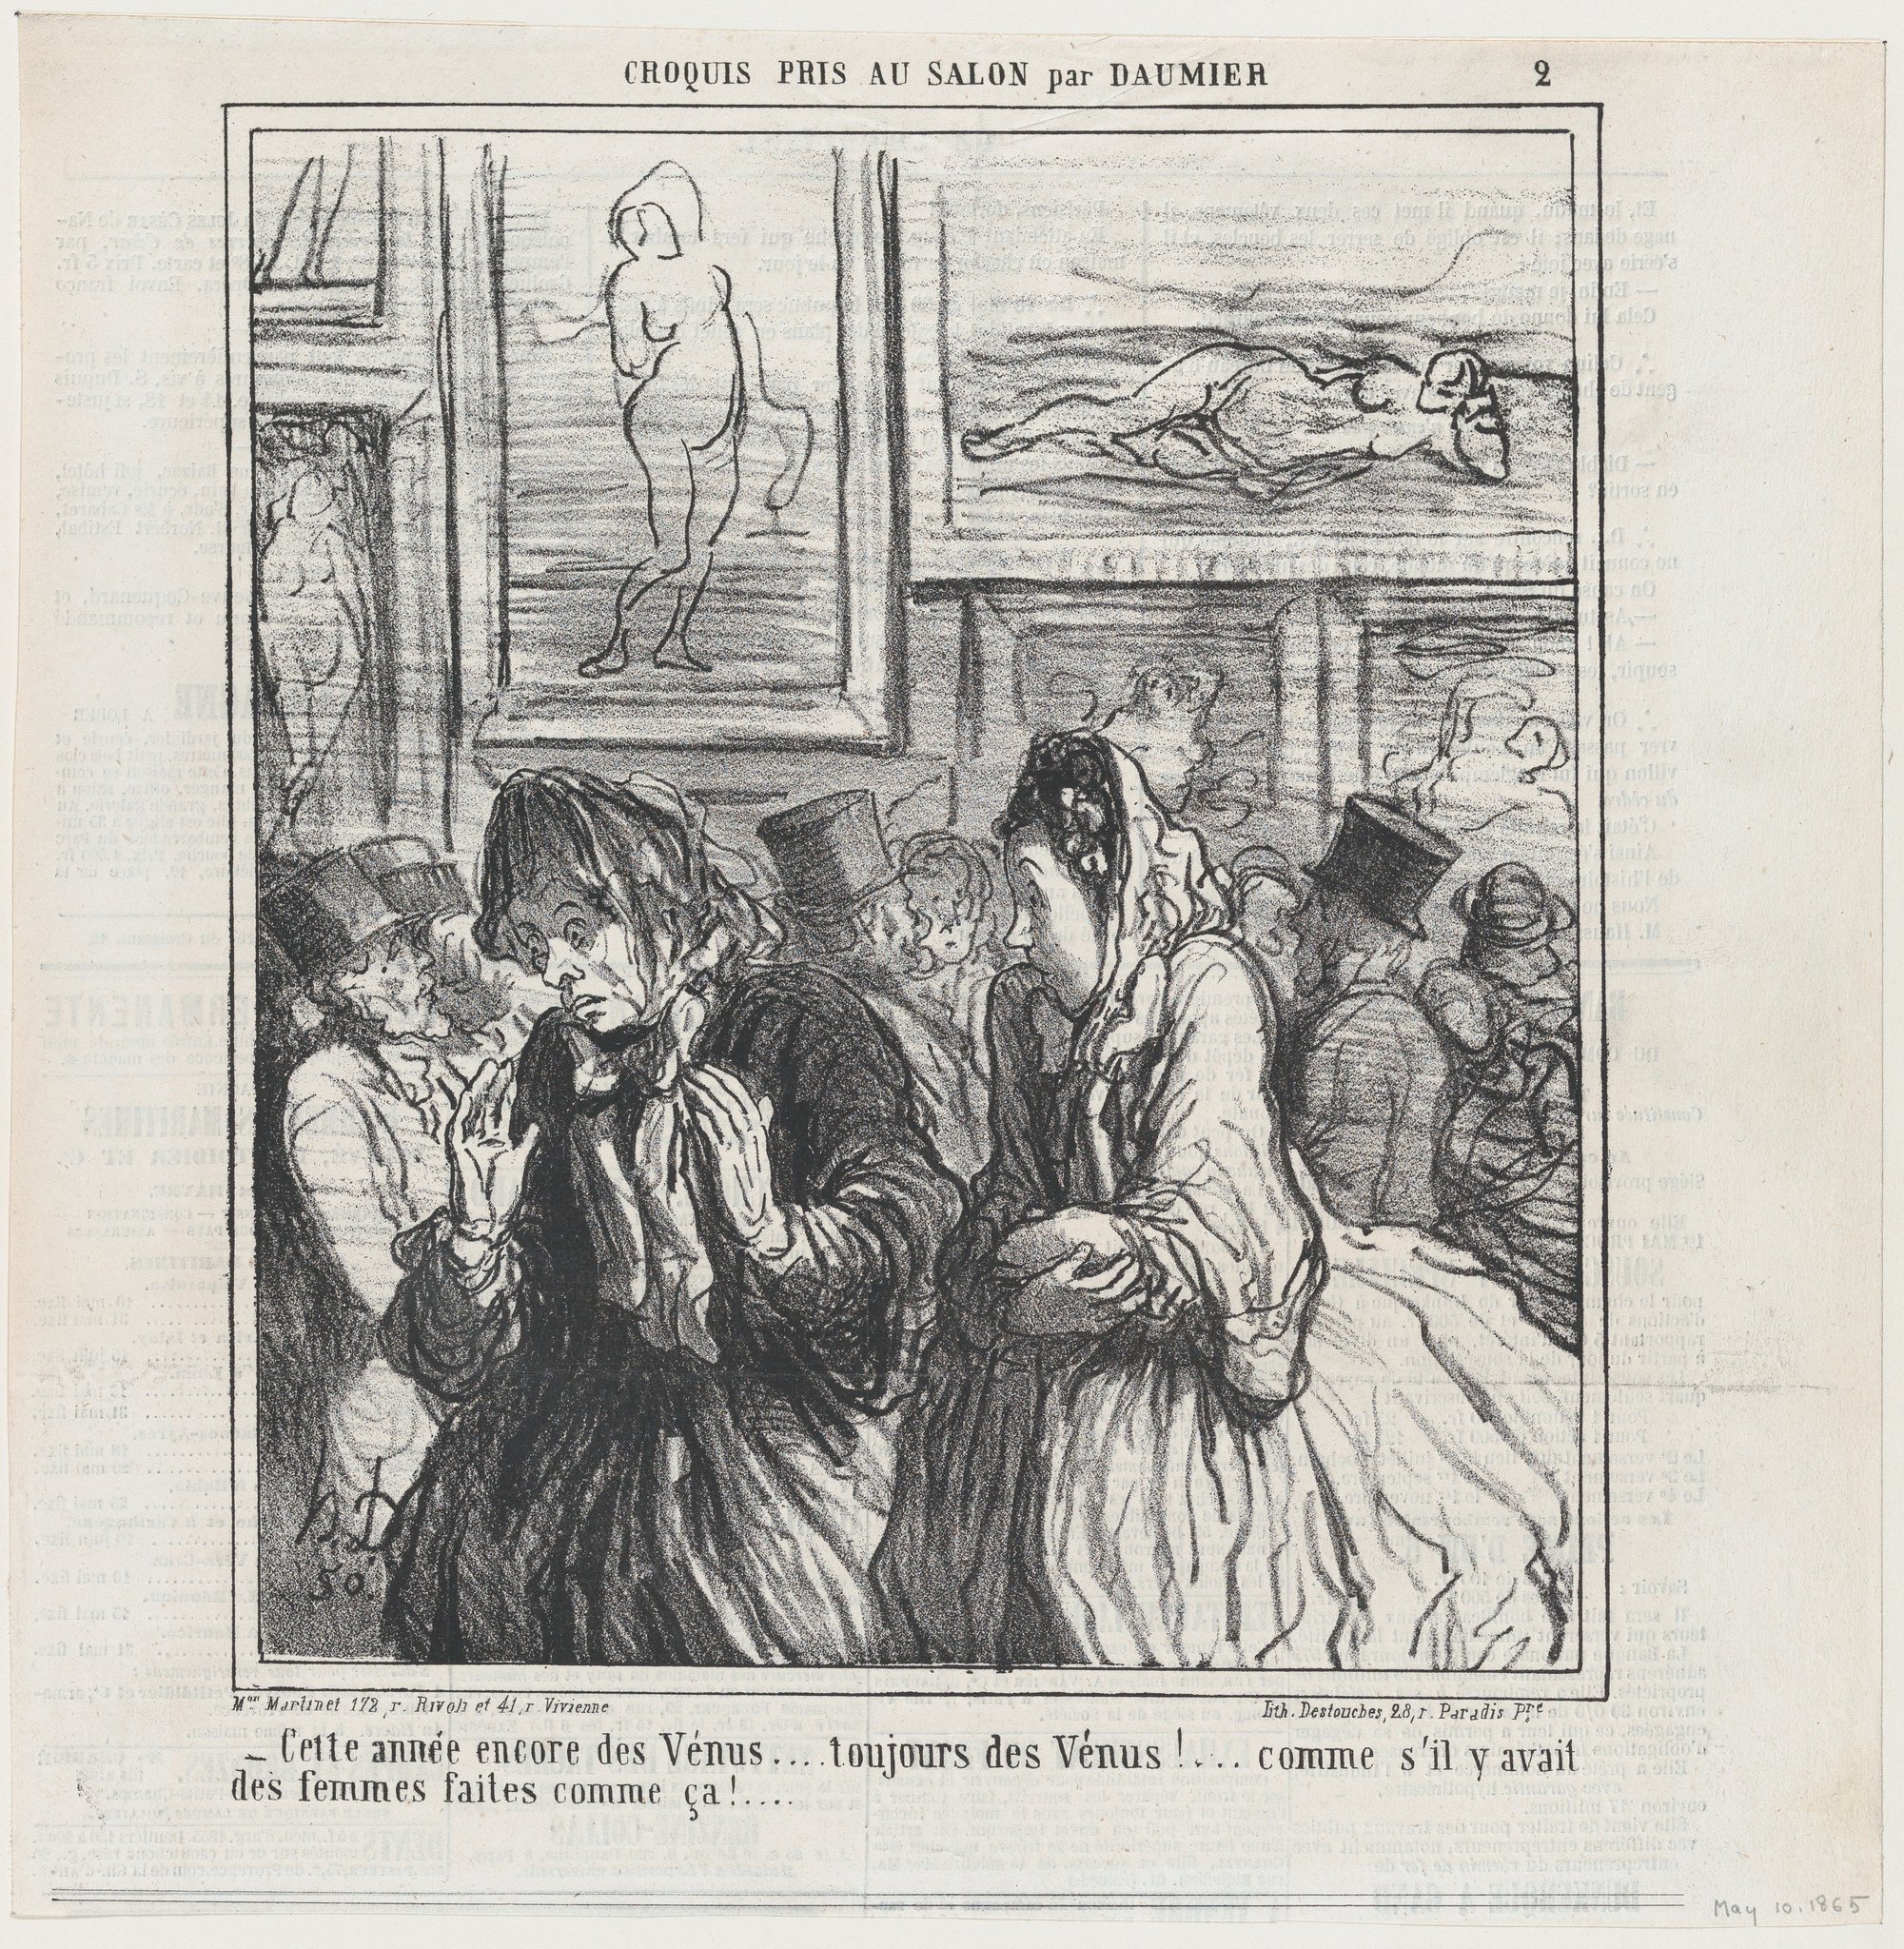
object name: print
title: Still more Venuses this year... always Venuses!... as if there were any women built like that!, from 'Sketches from the Salon,' published in Le Charivari, May 10, 1865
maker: honoré daumier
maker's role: artist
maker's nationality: french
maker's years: 1808-1879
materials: paper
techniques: lithograph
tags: satire,men,women